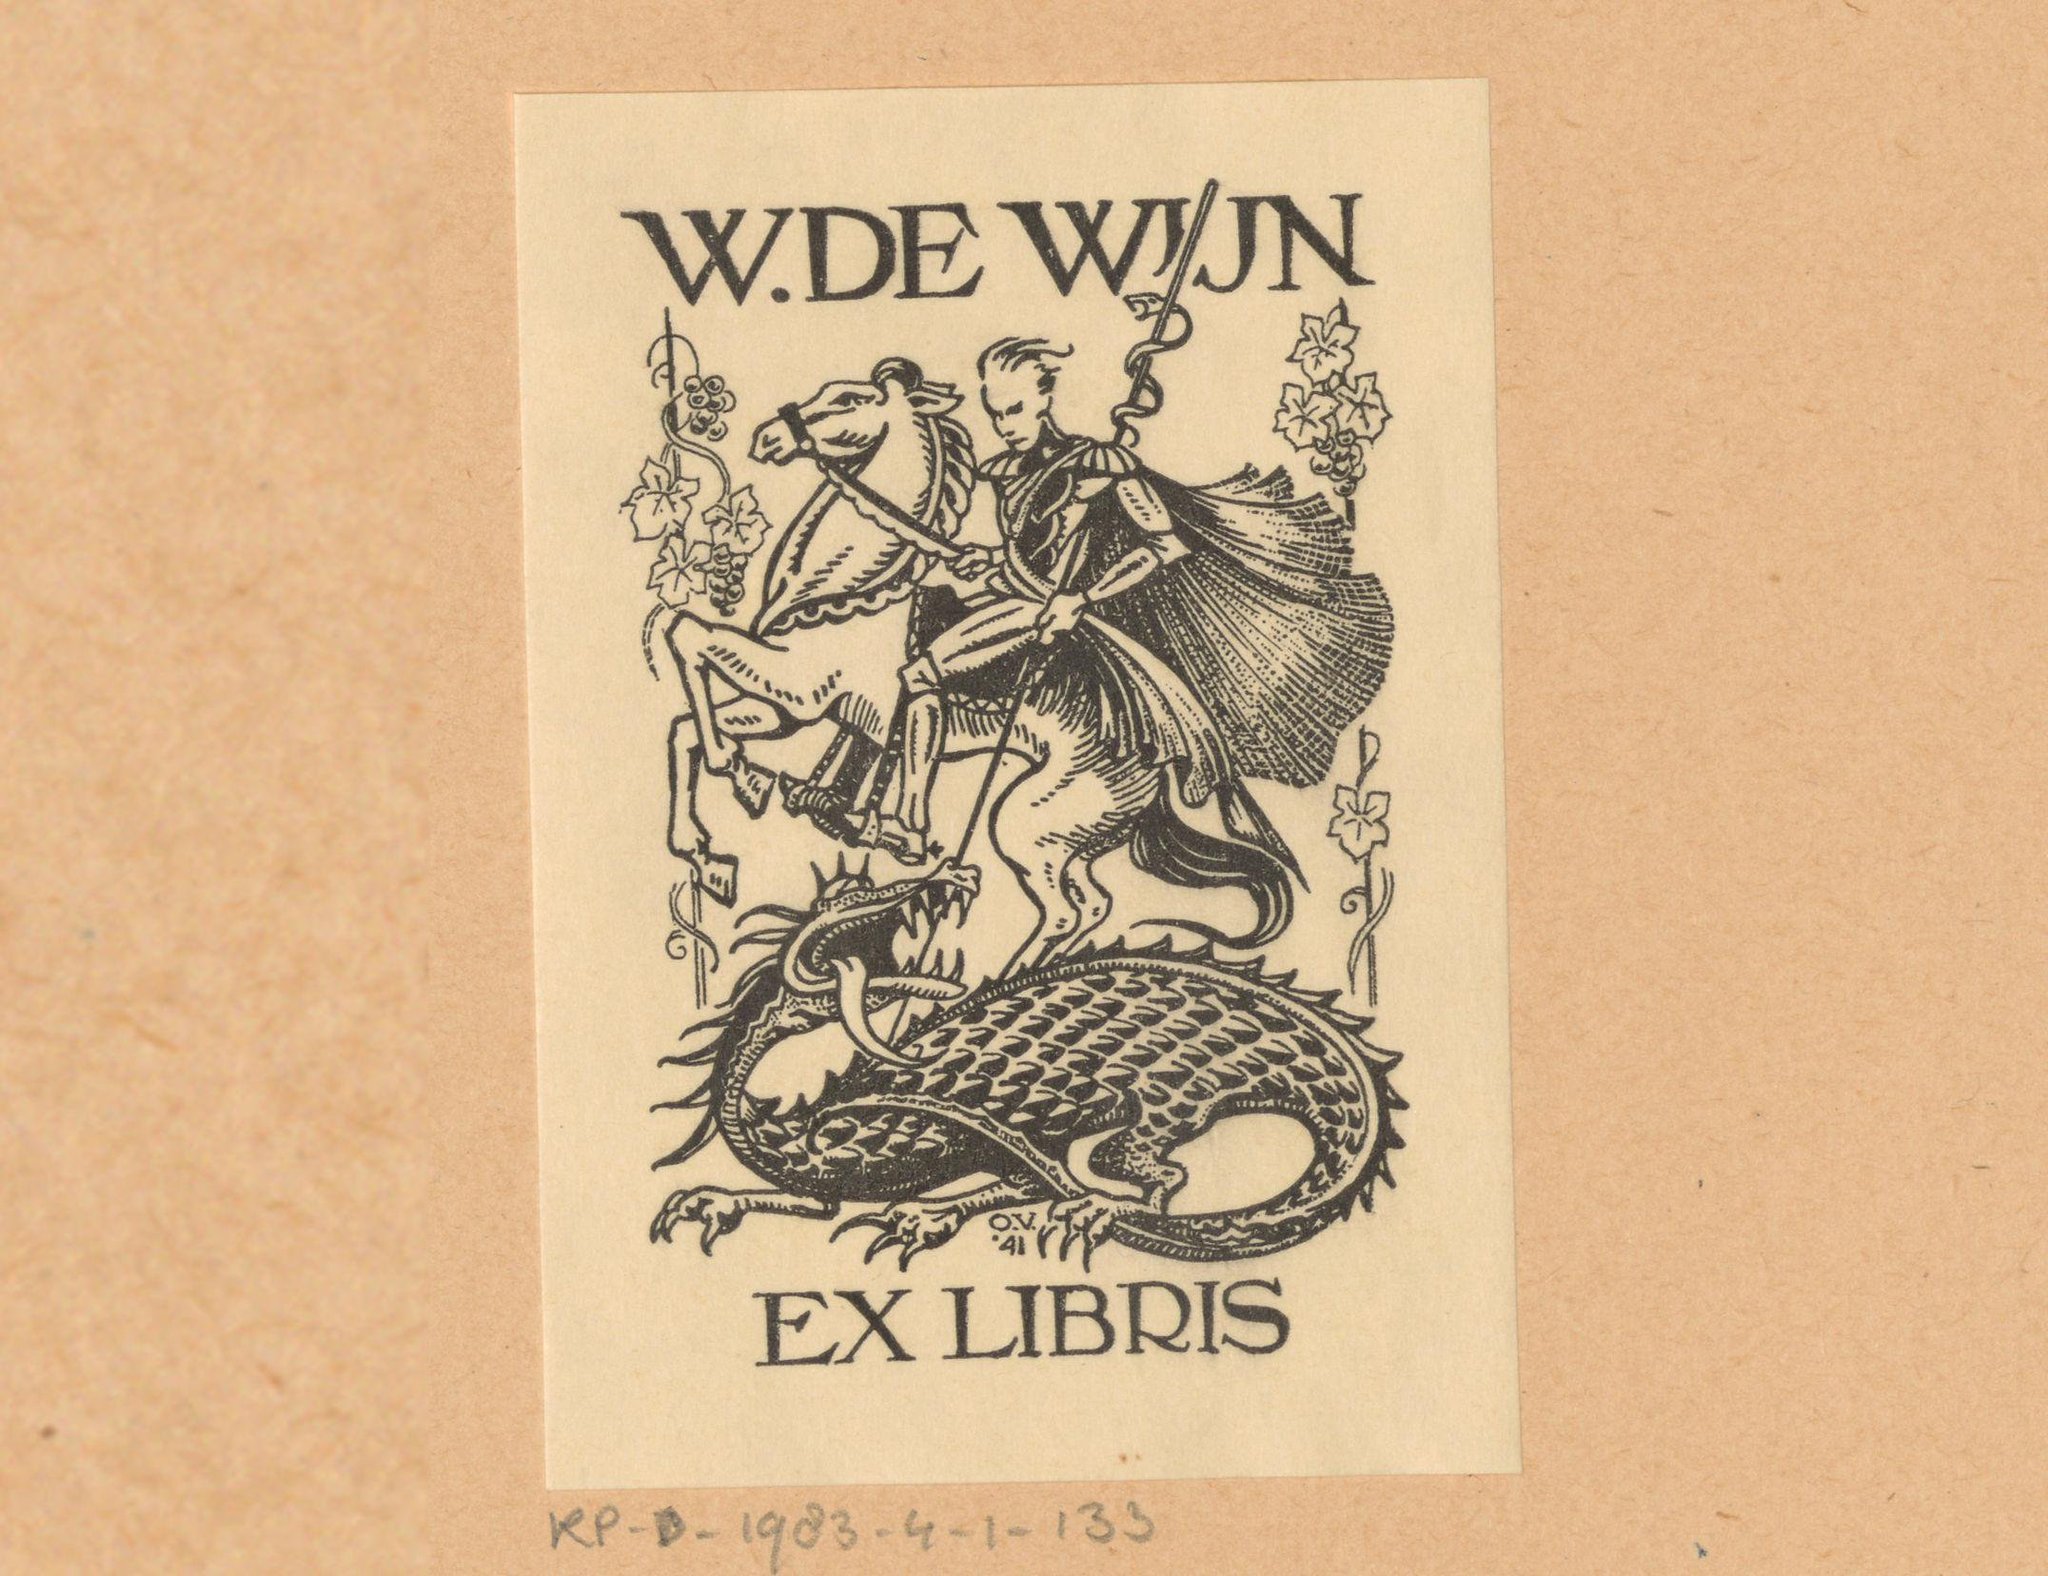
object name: bookplate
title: Ex libris van W. de Wijn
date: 1941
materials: paper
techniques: printing block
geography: netherlands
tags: vine, dragon, horse, aesculapian sign, the warrior martyr george (georgius); possible attributes: banner (red cross on white field), (red) cross, dragon, (white) horse, broken lance, shield (with cross), sword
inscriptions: inscription: ‘Clichédruk Jaar 1941. (...) 61, illustratie no. 539.’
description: Ontwerp voor een arts. Met zijn lans, tevens aesculaap, doodt hij de draak die staat voor ziekte. De Wijn was werkzaam in Ridderkerk, vandaar dat gekozen is voor Sint Joris met de draak. Ex libris is opgenomen in M.C. Croockewit, "Het ex libris der Nederlandsche medici", 1950.